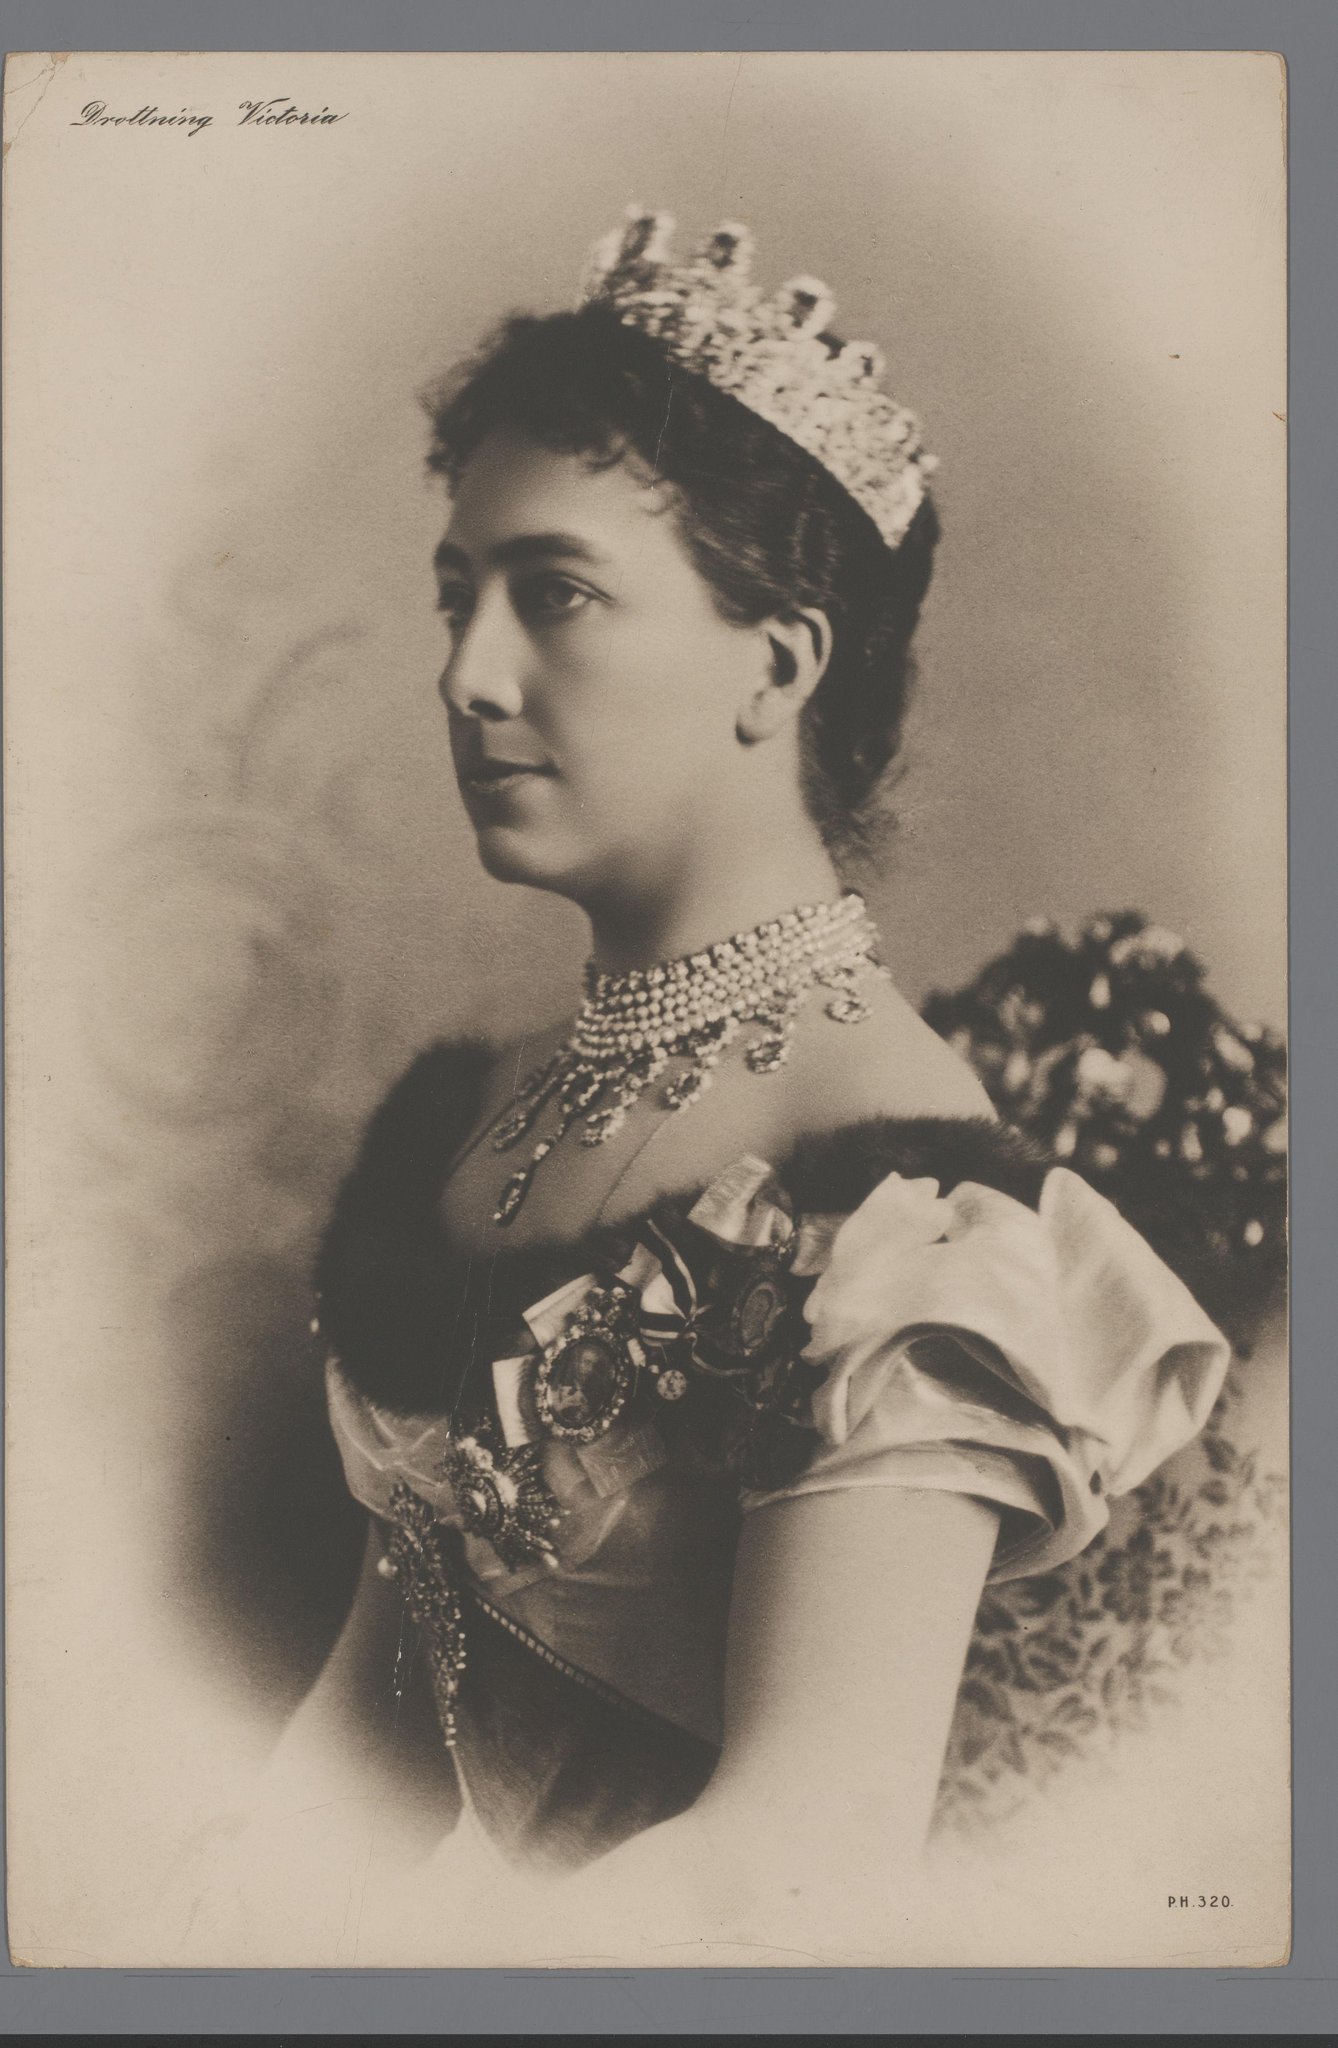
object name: photograph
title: Drottning Victoria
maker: Anonymous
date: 1890-1903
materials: paper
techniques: gelatin silver print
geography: sweden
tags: rome, historical persons, queen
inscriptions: number: ‘P.H. 320.’, inscription: ‘Sophie Maria Victoria, geb (...)’, inscription: ‘[onleesbaar]’